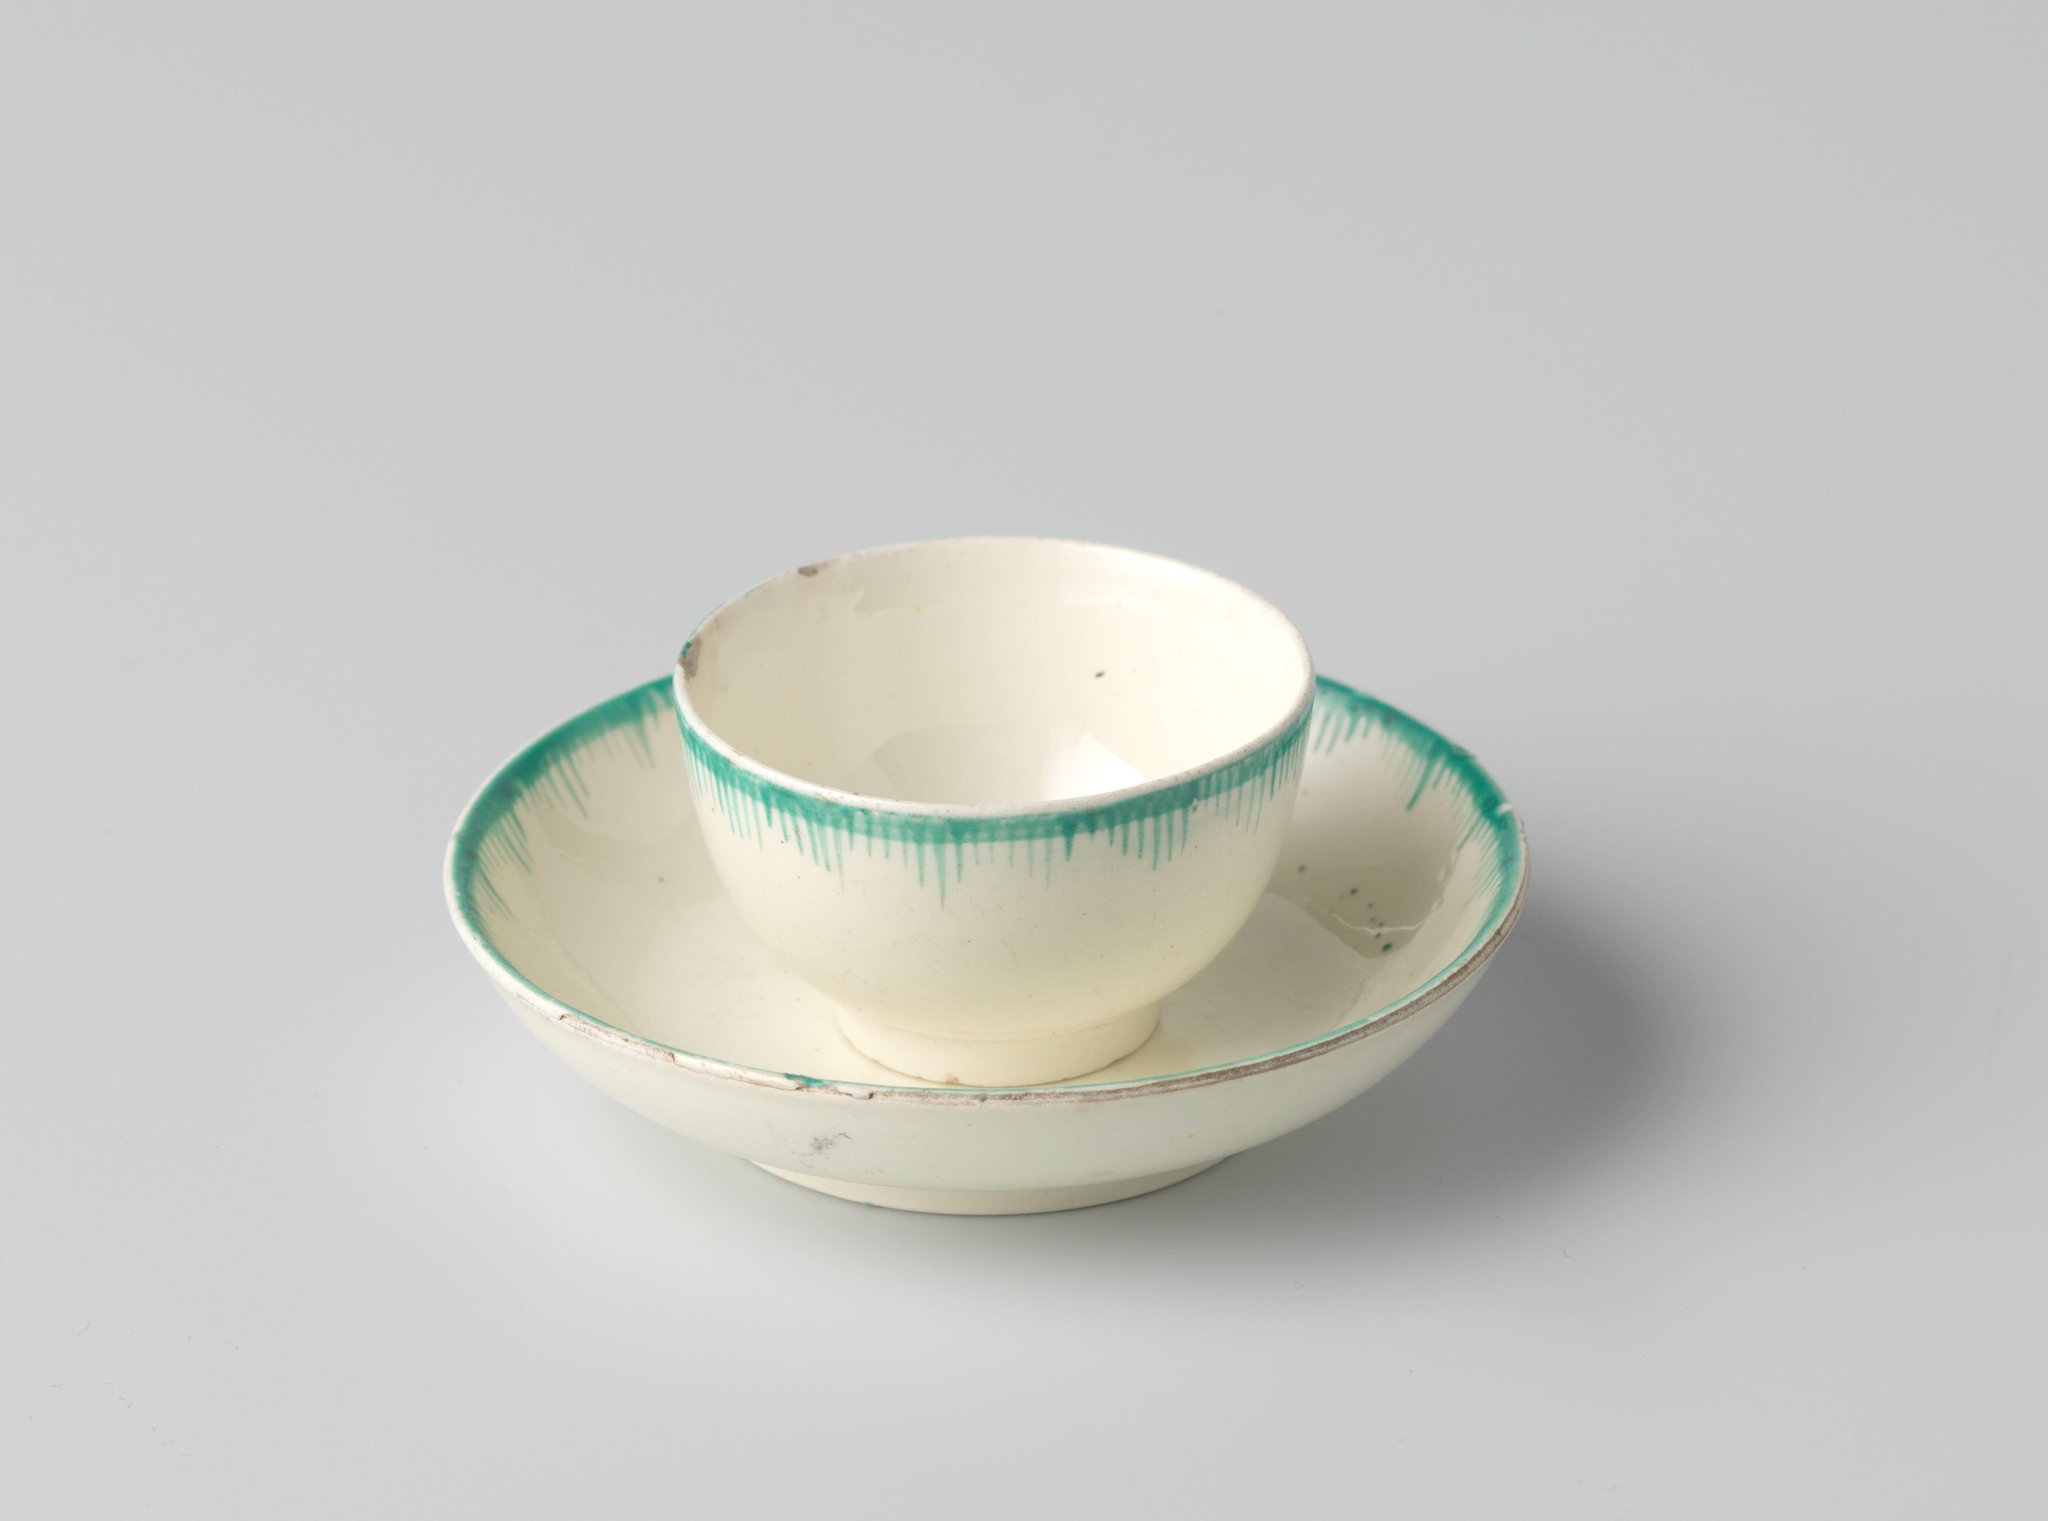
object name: platter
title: Schotel van hardgebakken aardewerk, creamware.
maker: Anonymous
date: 1790-1810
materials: earthenware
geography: england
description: Schotel van hardgebakken aardewerk, van een kinderservies. Schotel heeft een groene uitstralende rand.